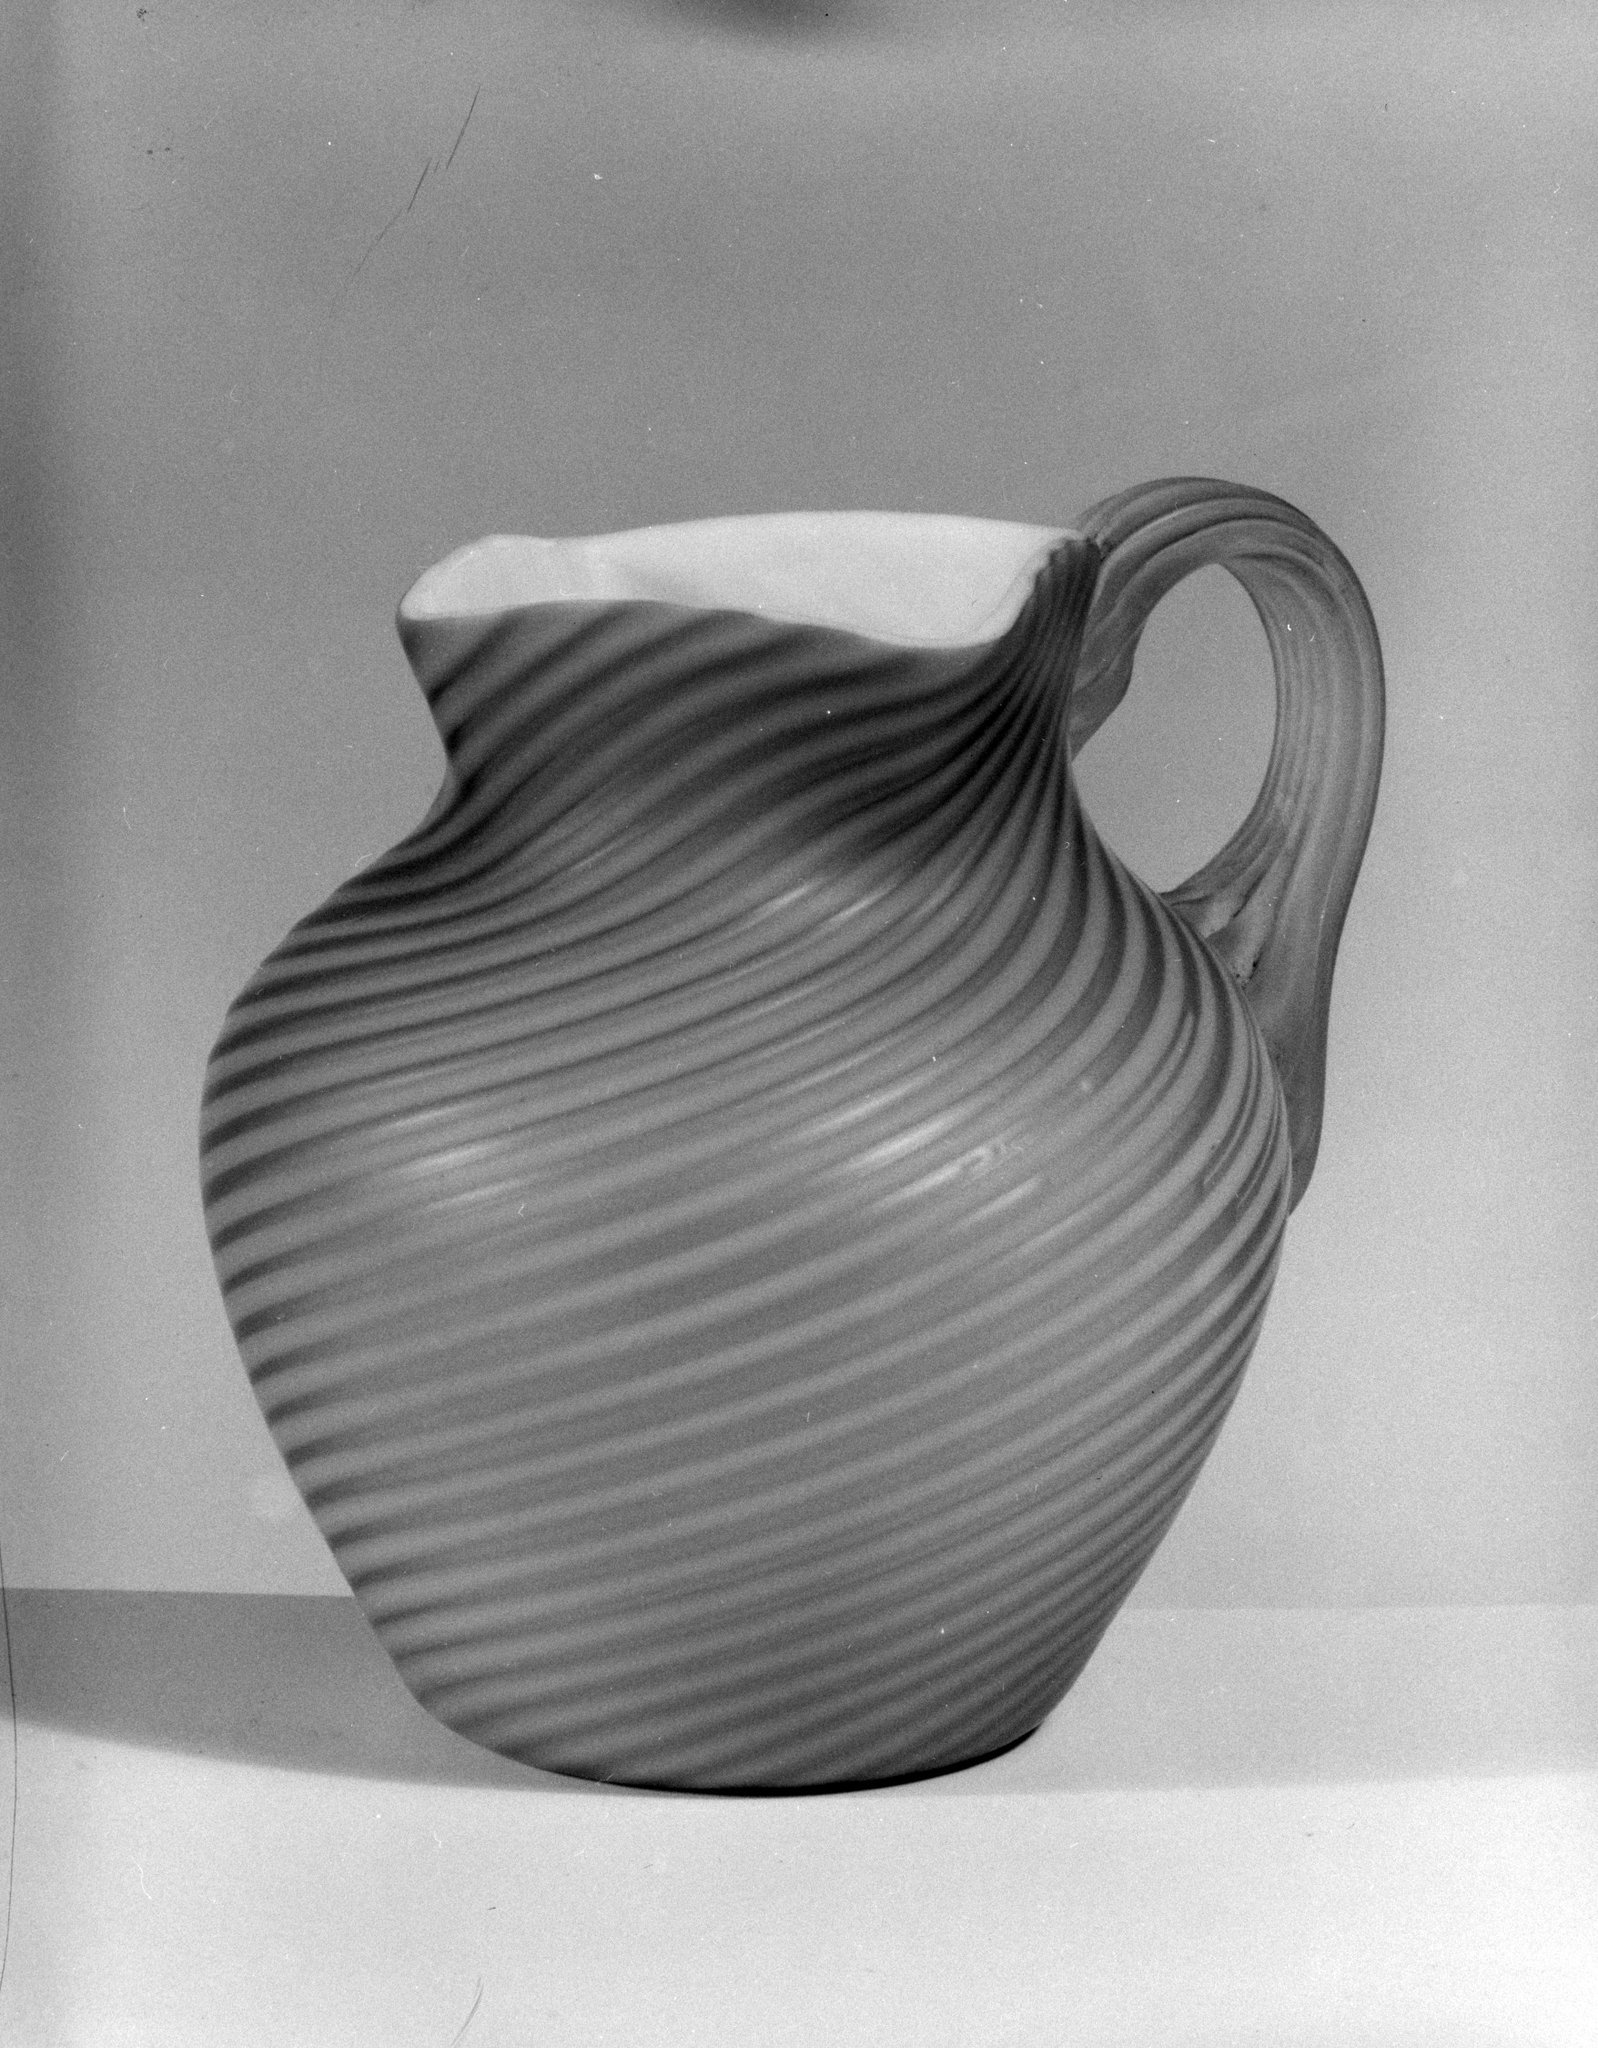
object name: pitcher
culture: british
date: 1885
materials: glass, textile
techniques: glassblowing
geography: england